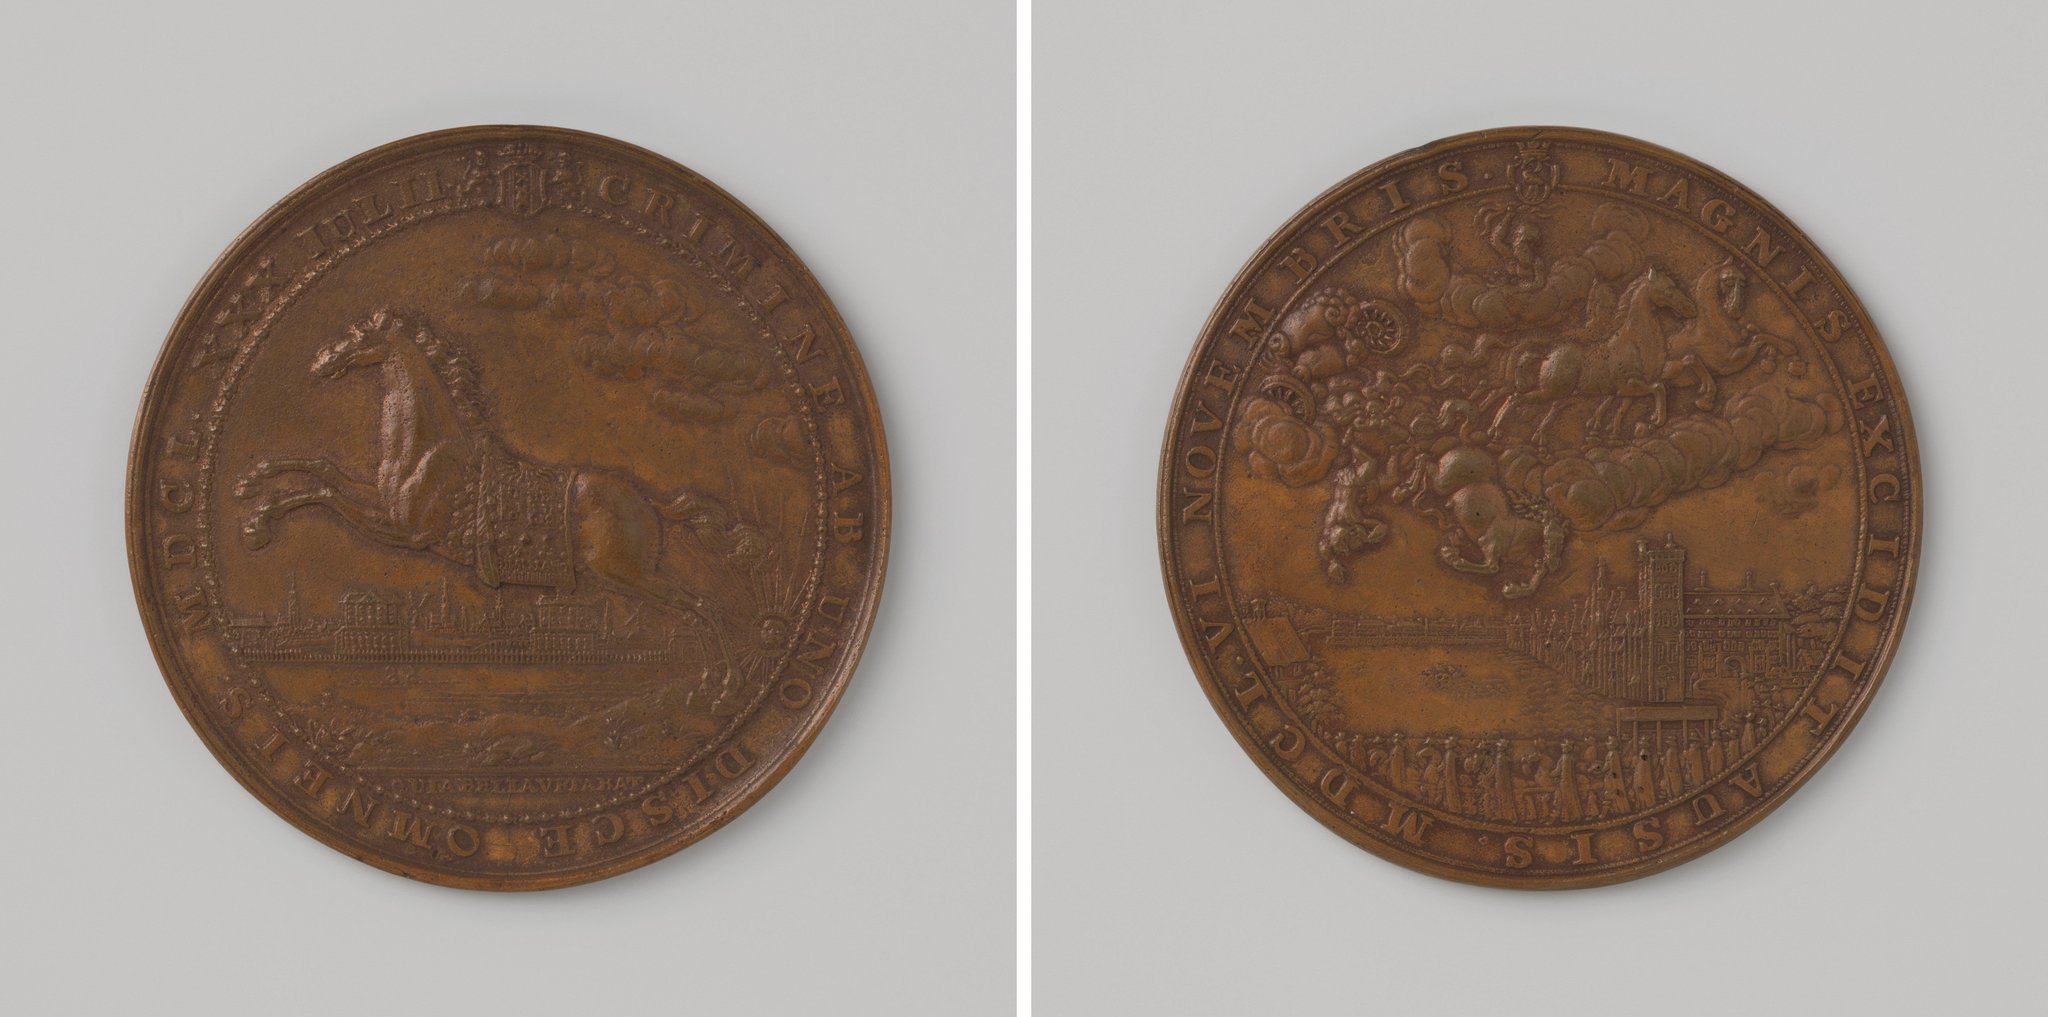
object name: history medal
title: Overlijden van stadhouder Prins Willem II 1650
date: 1650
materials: copper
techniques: casting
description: Gegoten koperen penning, op de voorzijde een springend paard tegen het aanzicht van Amsterdam vanaf de Amstel bij opkomende zon, met omschrift en afsnedetekst, op de keerzijde de lijkstoet van Willem in Den Haag op weg naar Delft met daarboven Phaëton die uit de hemelwagen stort, met omschrift.